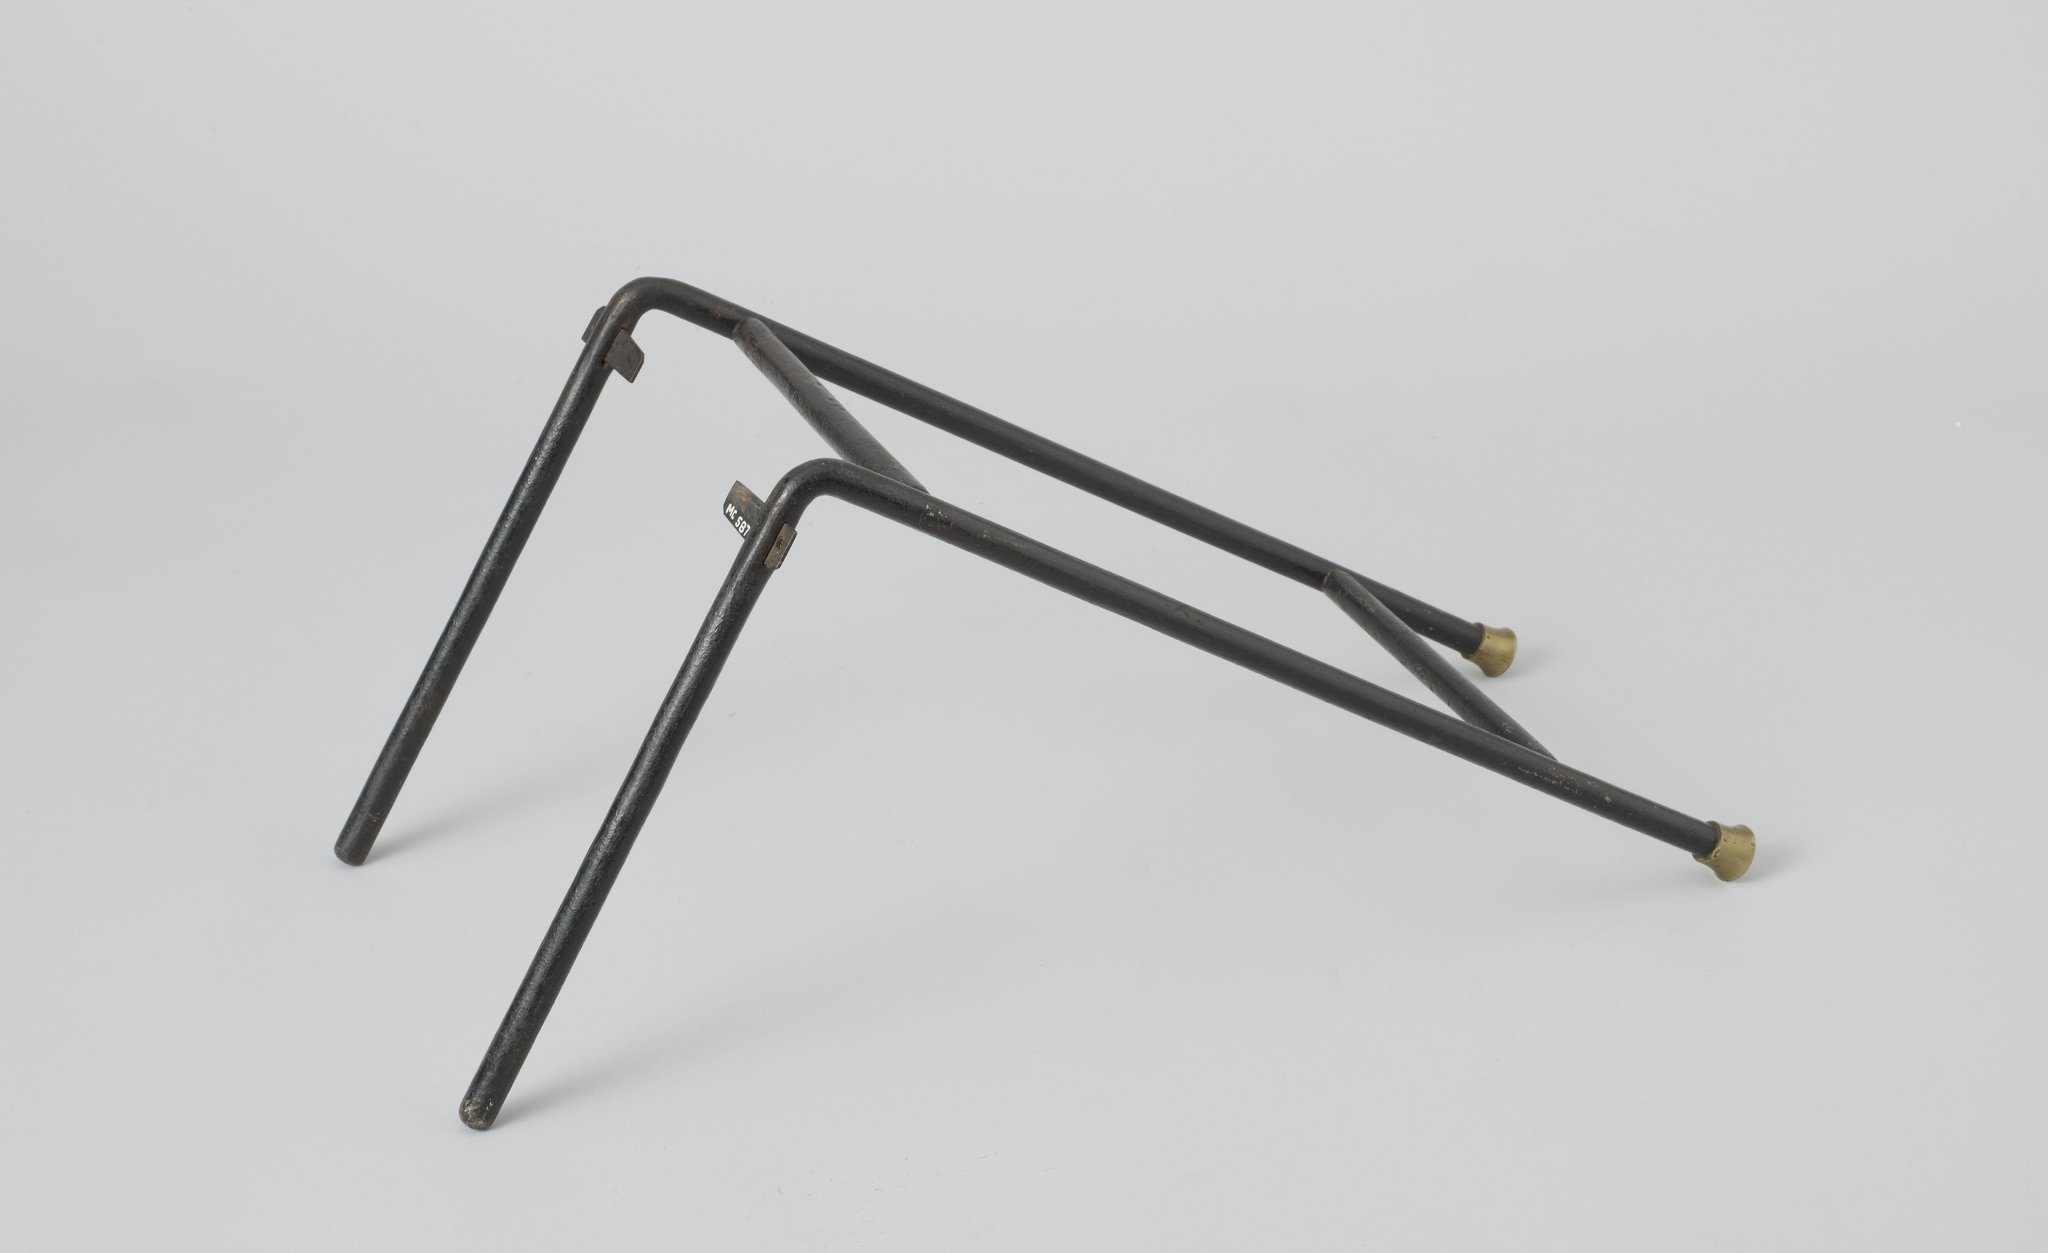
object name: scale model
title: Model of the Leg of a Bench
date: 1854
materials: brass, iron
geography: leiden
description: Dubbele poot voor een bank bestaande uit een zwart ijzeren frame met messing beschermdoppen aan de voeten, in een rechte hoek gebogen ter hoogte van de zitting, waar ook twee keggen voor de bevestiging zitten.